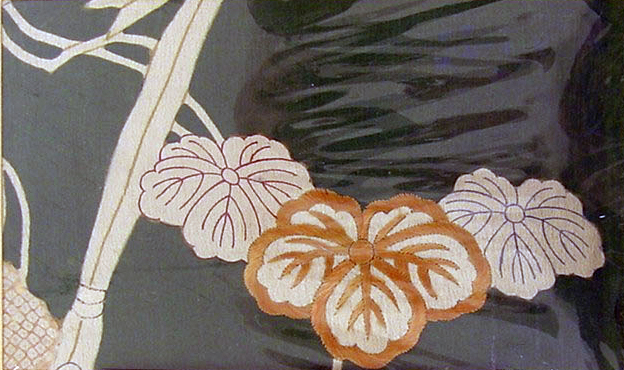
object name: piece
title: Textile with Leaves and Garden Fence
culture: japanese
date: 1615-1868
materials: silk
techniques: dyeing, embroidery, painting, weave, resist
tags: leaves